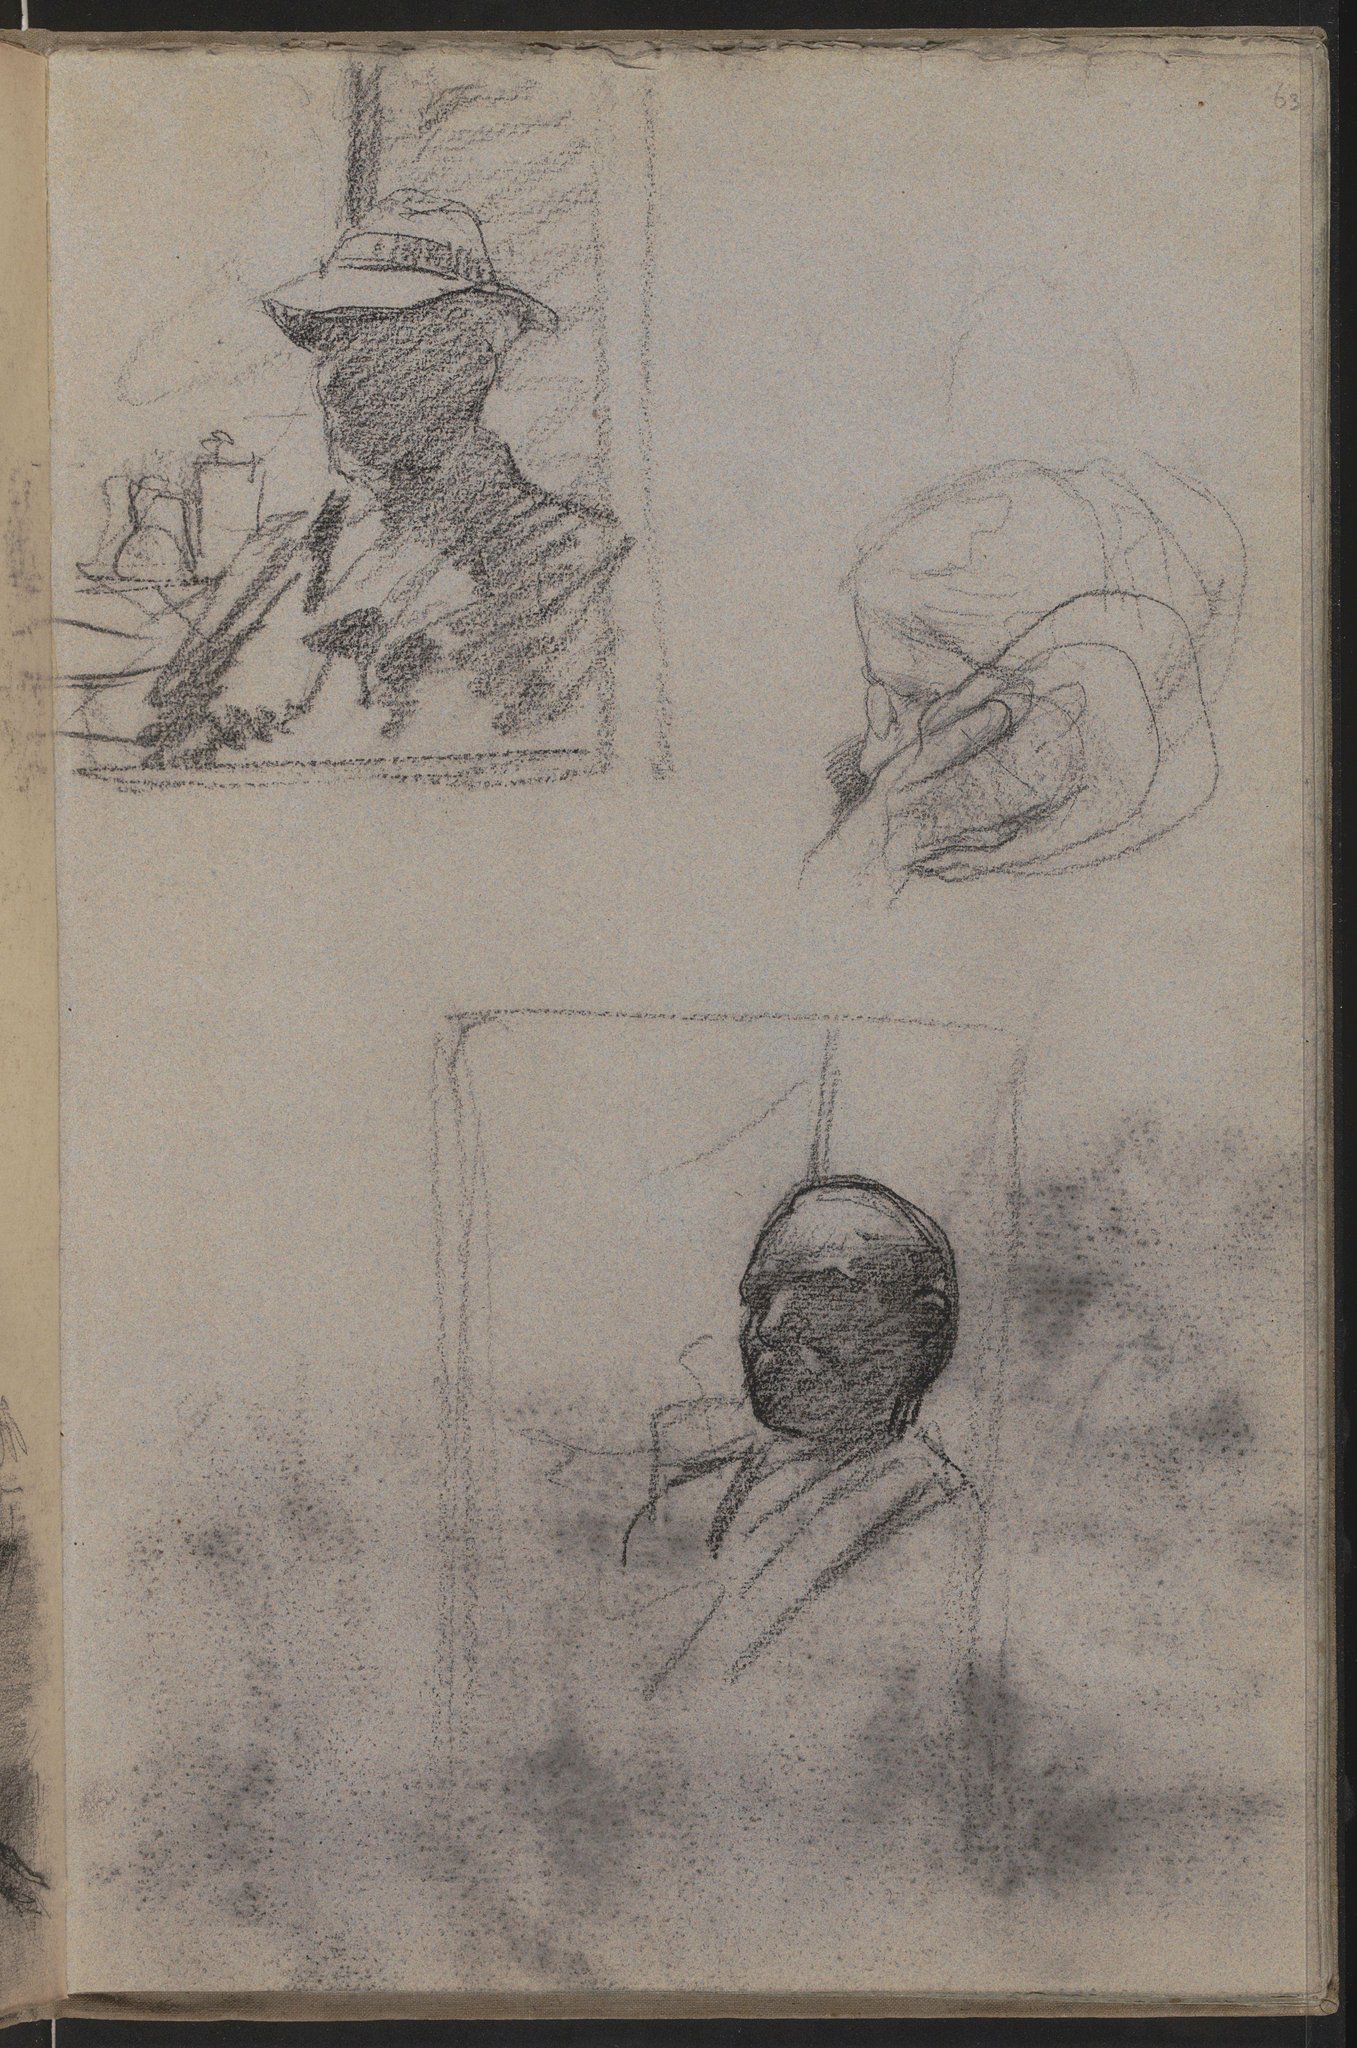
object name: sketchbook leaf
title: Twee mannenbustes en een vrouwenhoofd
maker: willem witsen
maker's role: draughtsman, painter, print maker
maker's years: 1860-1923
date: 1884-1887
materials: chalk, paper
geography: ewijkshoeve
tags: head (human), head (human) - aa - female human figure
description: Pagina 63 uit een schetsboek met 45 bladen vervaardigd rond de Ewijkshoeve.